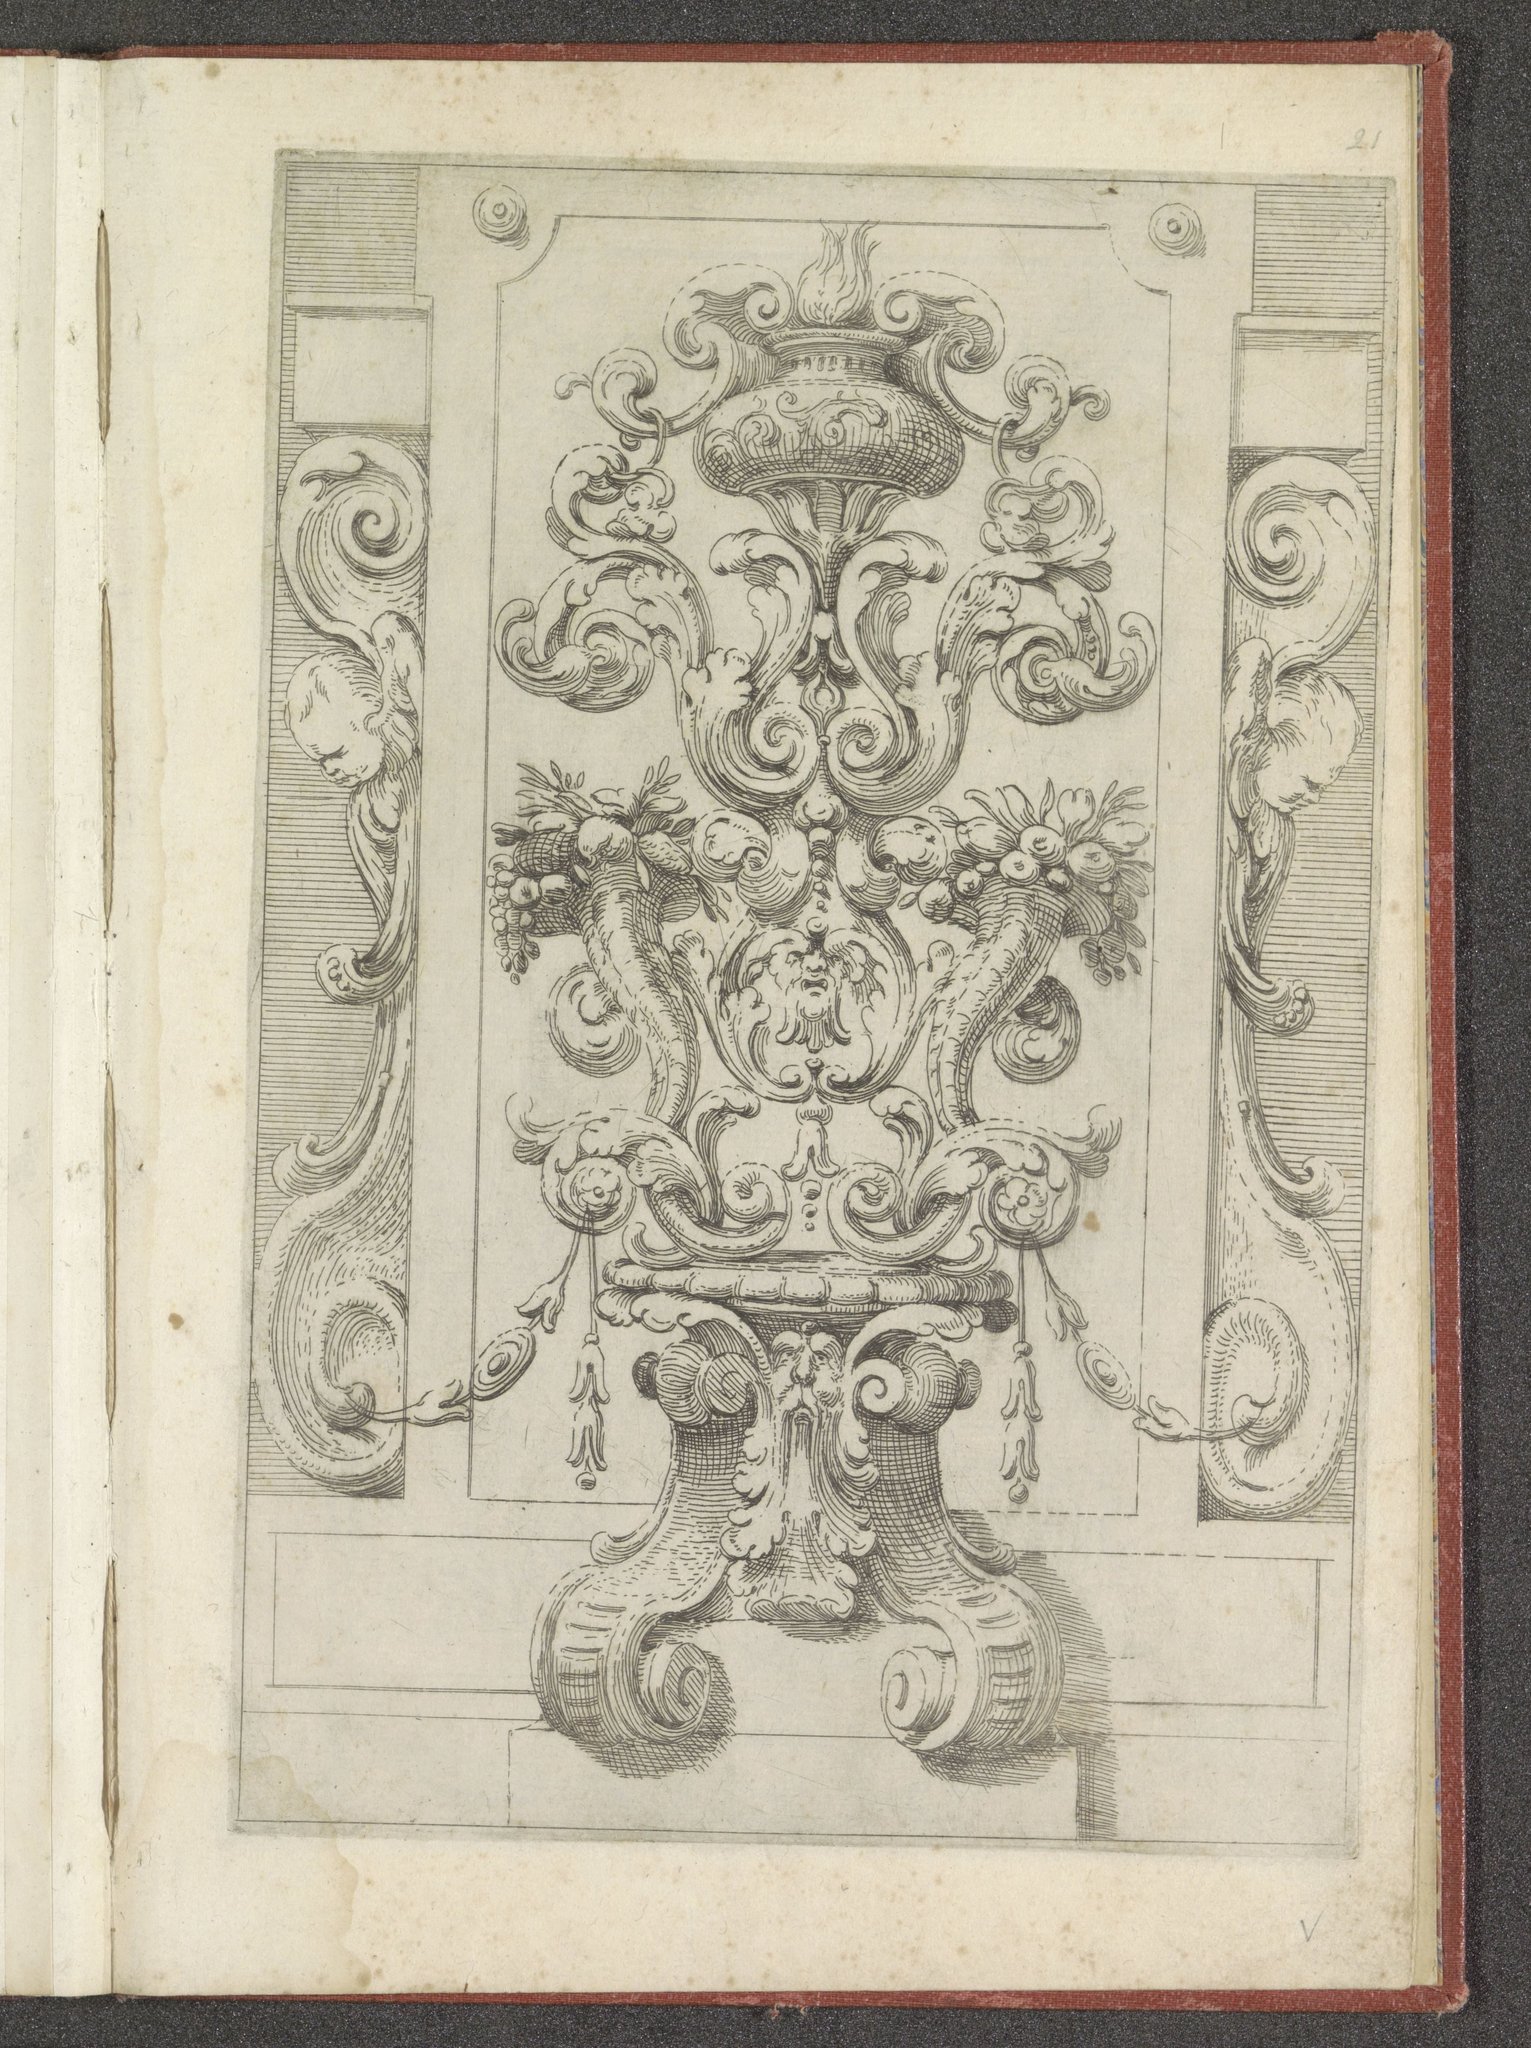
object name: album leaf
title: Monument met rocailles, hoornen met vruchten en cherubijnen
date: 1636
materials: paper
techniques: etching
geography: bologna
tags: cherubs, i.e. children's heads with wings, 'cornucopia', horn of plenty, rocaille ornament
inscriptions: collector's mark: Lugt 2228, collector's mark: Lugt 2760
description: Een monument met rocailles, hoornen met vruchten en cherubijnen. De prent maakt deel uit van een album.